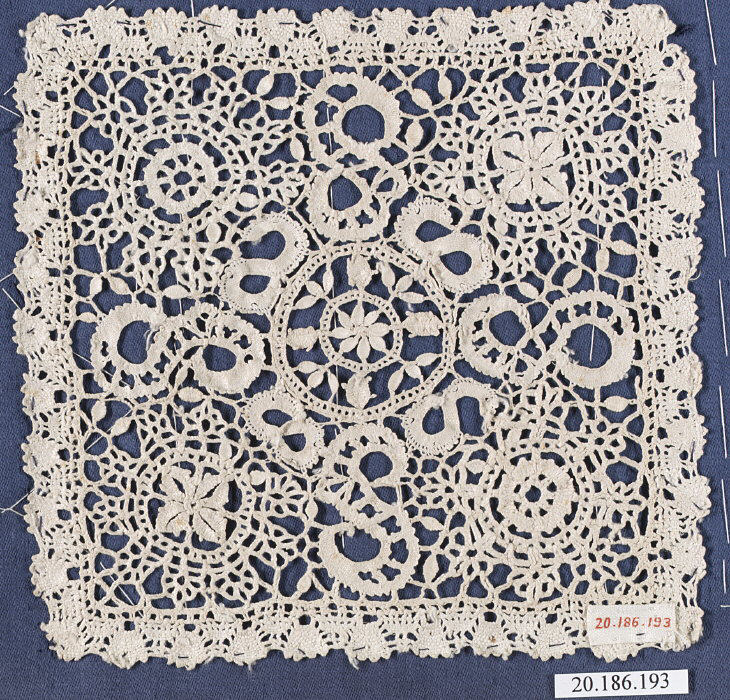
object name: square or pall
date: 1601-1700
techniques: lace